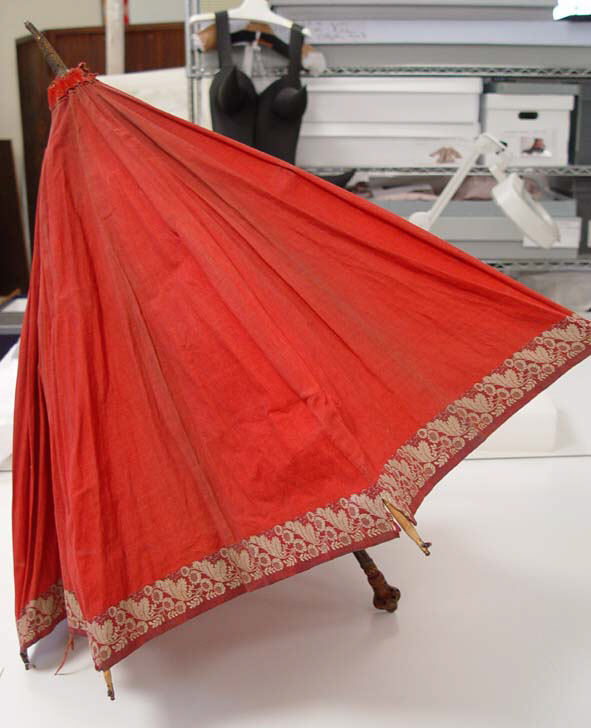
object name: umbrella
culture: european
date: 1801-1833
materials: cotton, metal, wood